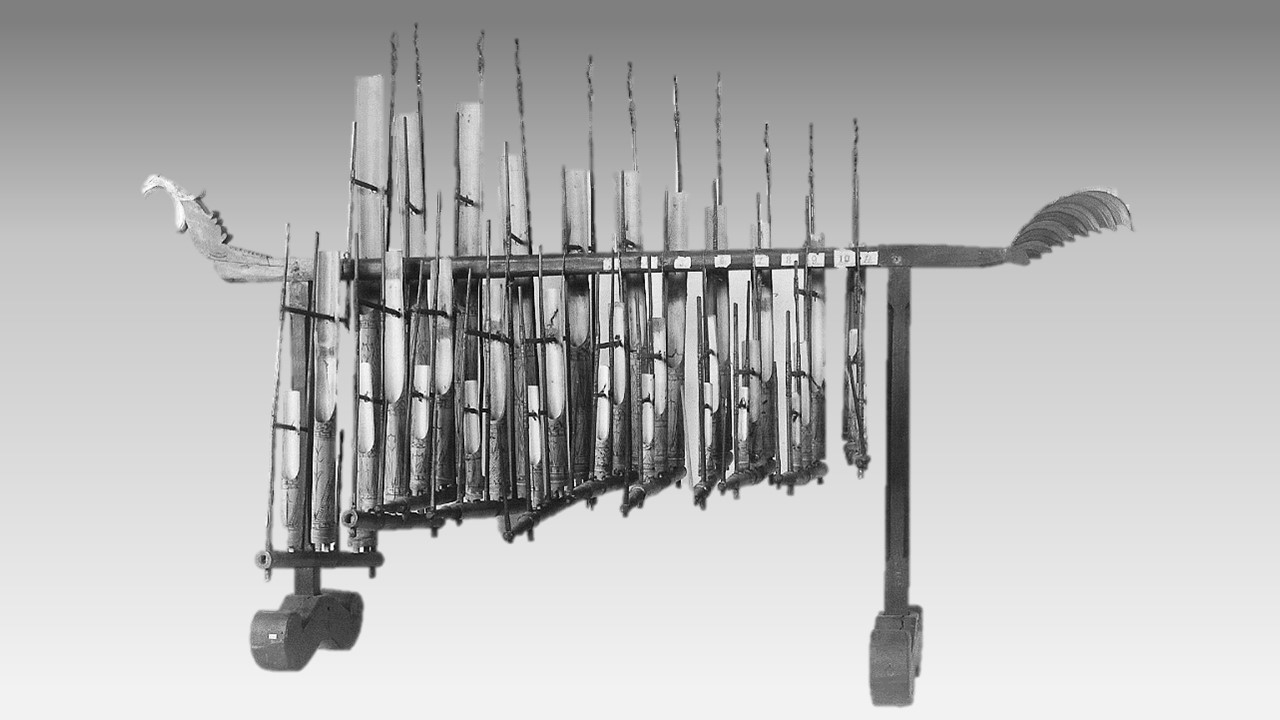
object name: angklung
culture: javanese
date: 1867-1900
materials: bamboo, wood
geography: indonesia